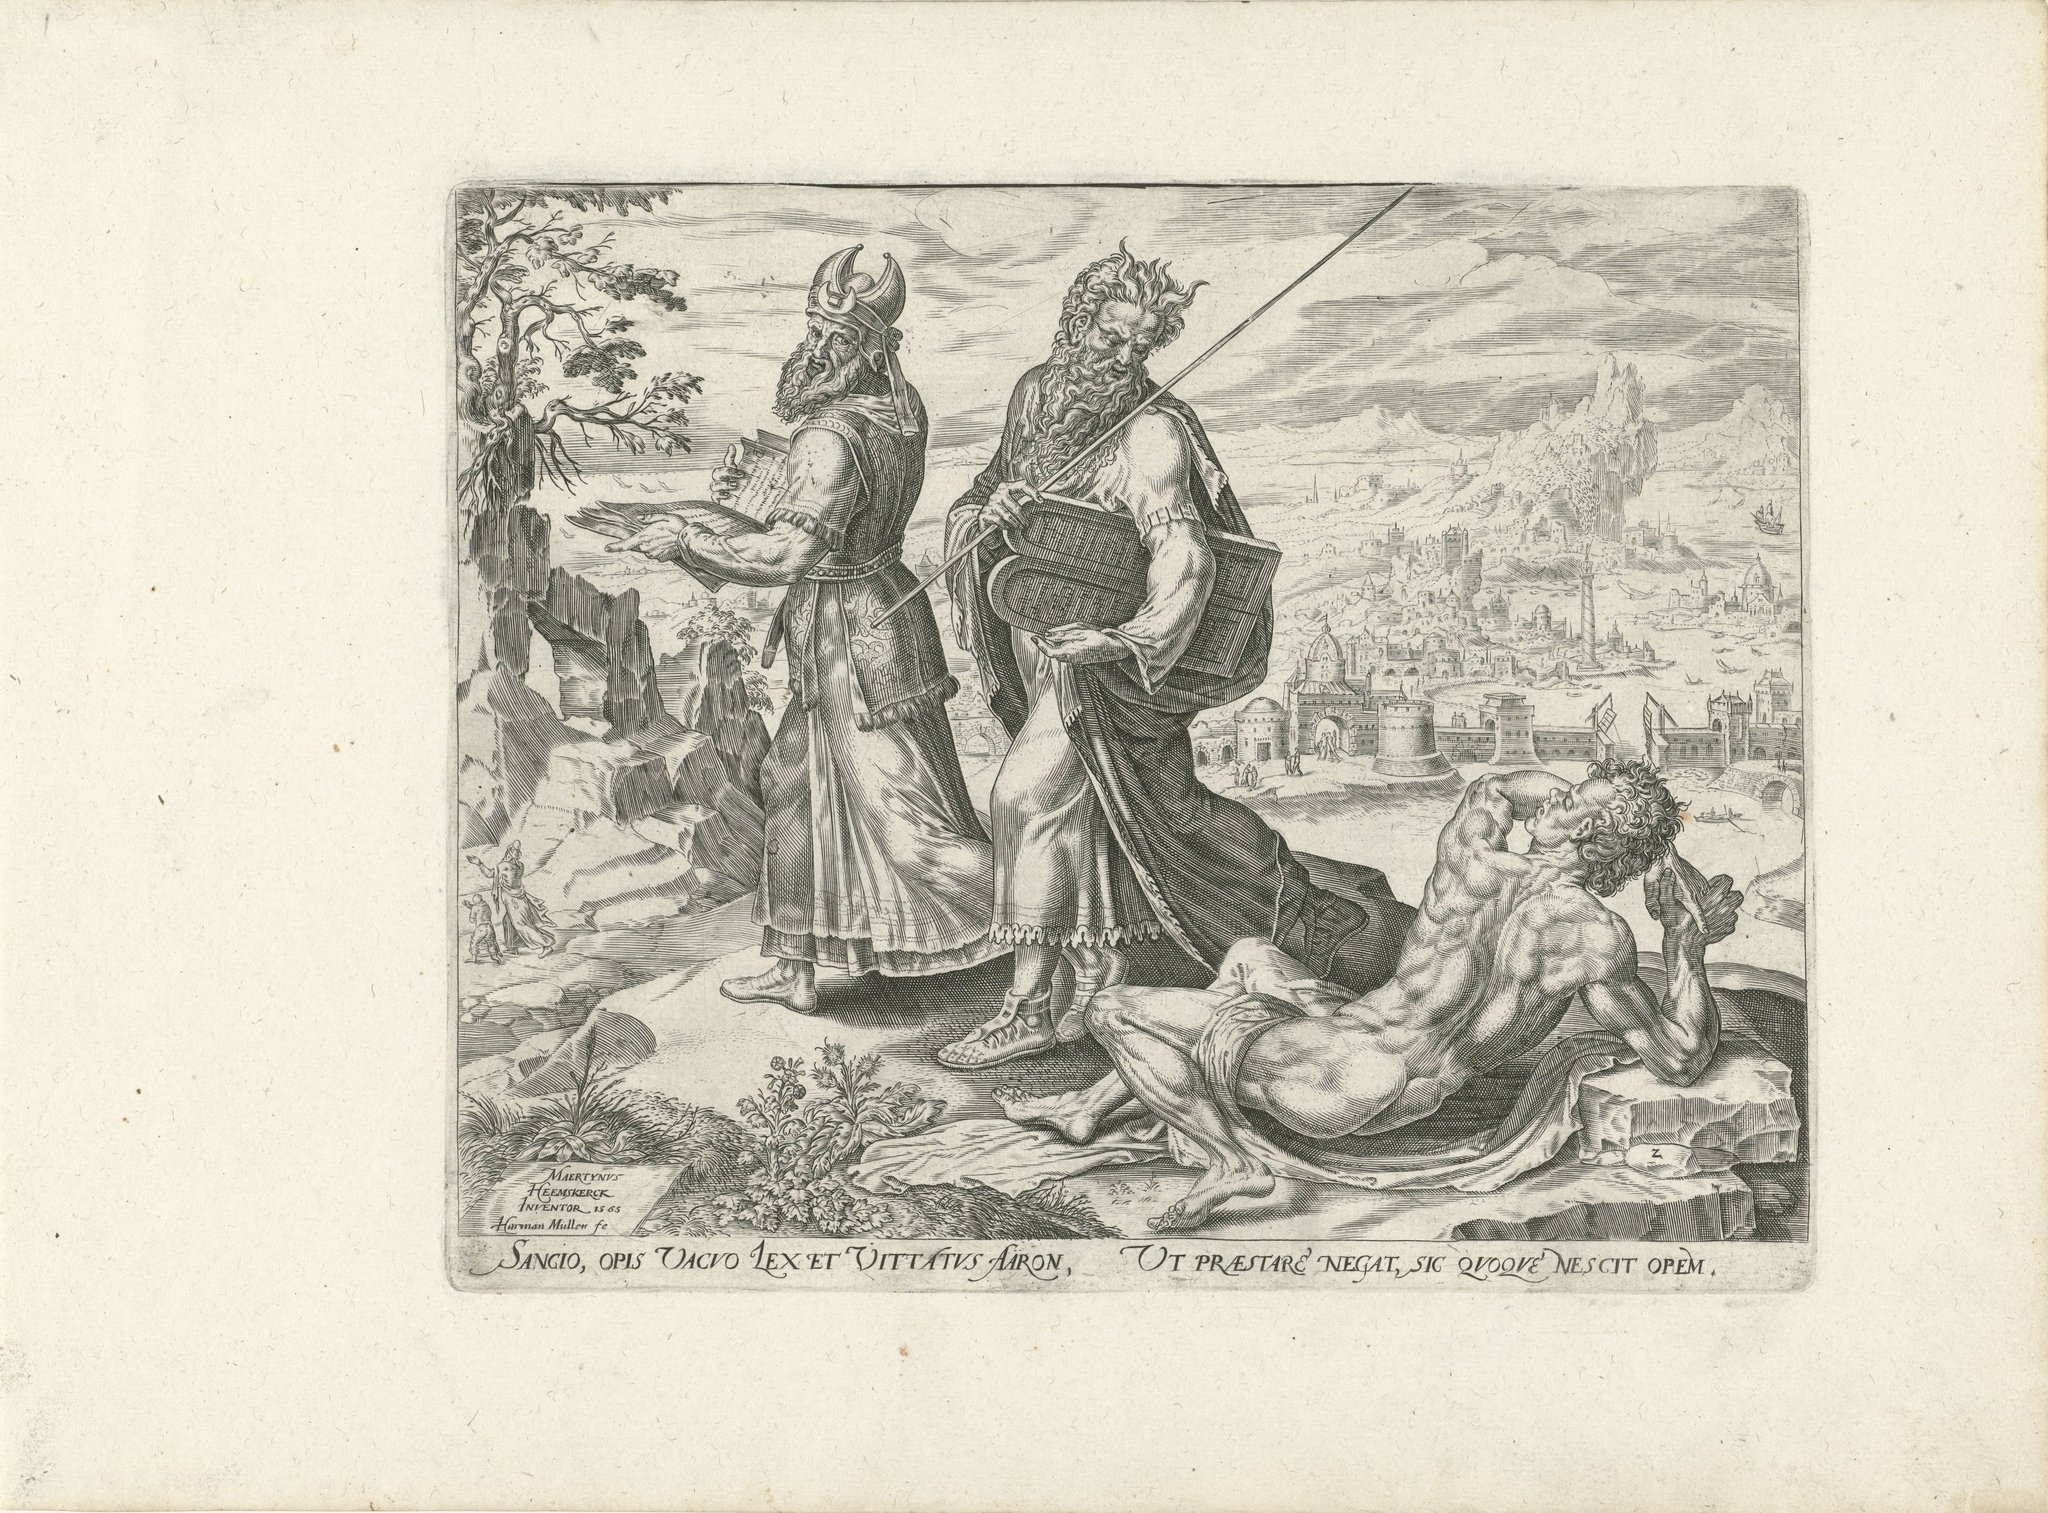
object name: print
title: Christus als de barmhartige Samaritaan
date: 1565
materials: paper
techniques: engraving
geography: amsterdam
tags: a priest and/or a levite passing by without attending to the wounded man ~ parable of the good samaritan (+ variant), aaron (not in biblical context); possible attributes: attributes of aaron: censer, dressed as high priest or bishop, ointment jar, rod or flowering wand, moses (not in biblical context); possible attributes: rays of light or horns on his head, rod, tables of the law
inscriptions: collector's mark: Lugt 2228, collector's mark: Lugt 2760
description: De gewonde Mens wordt voorbij gelopen door Mozes, met de tafelen der wet onder de arm, en Aäron. Op de achtergrond een landschap. Onderaan in de marge een vers in het Latijn. Variant op de gelijkenis van de barmhartige Samaritaan.